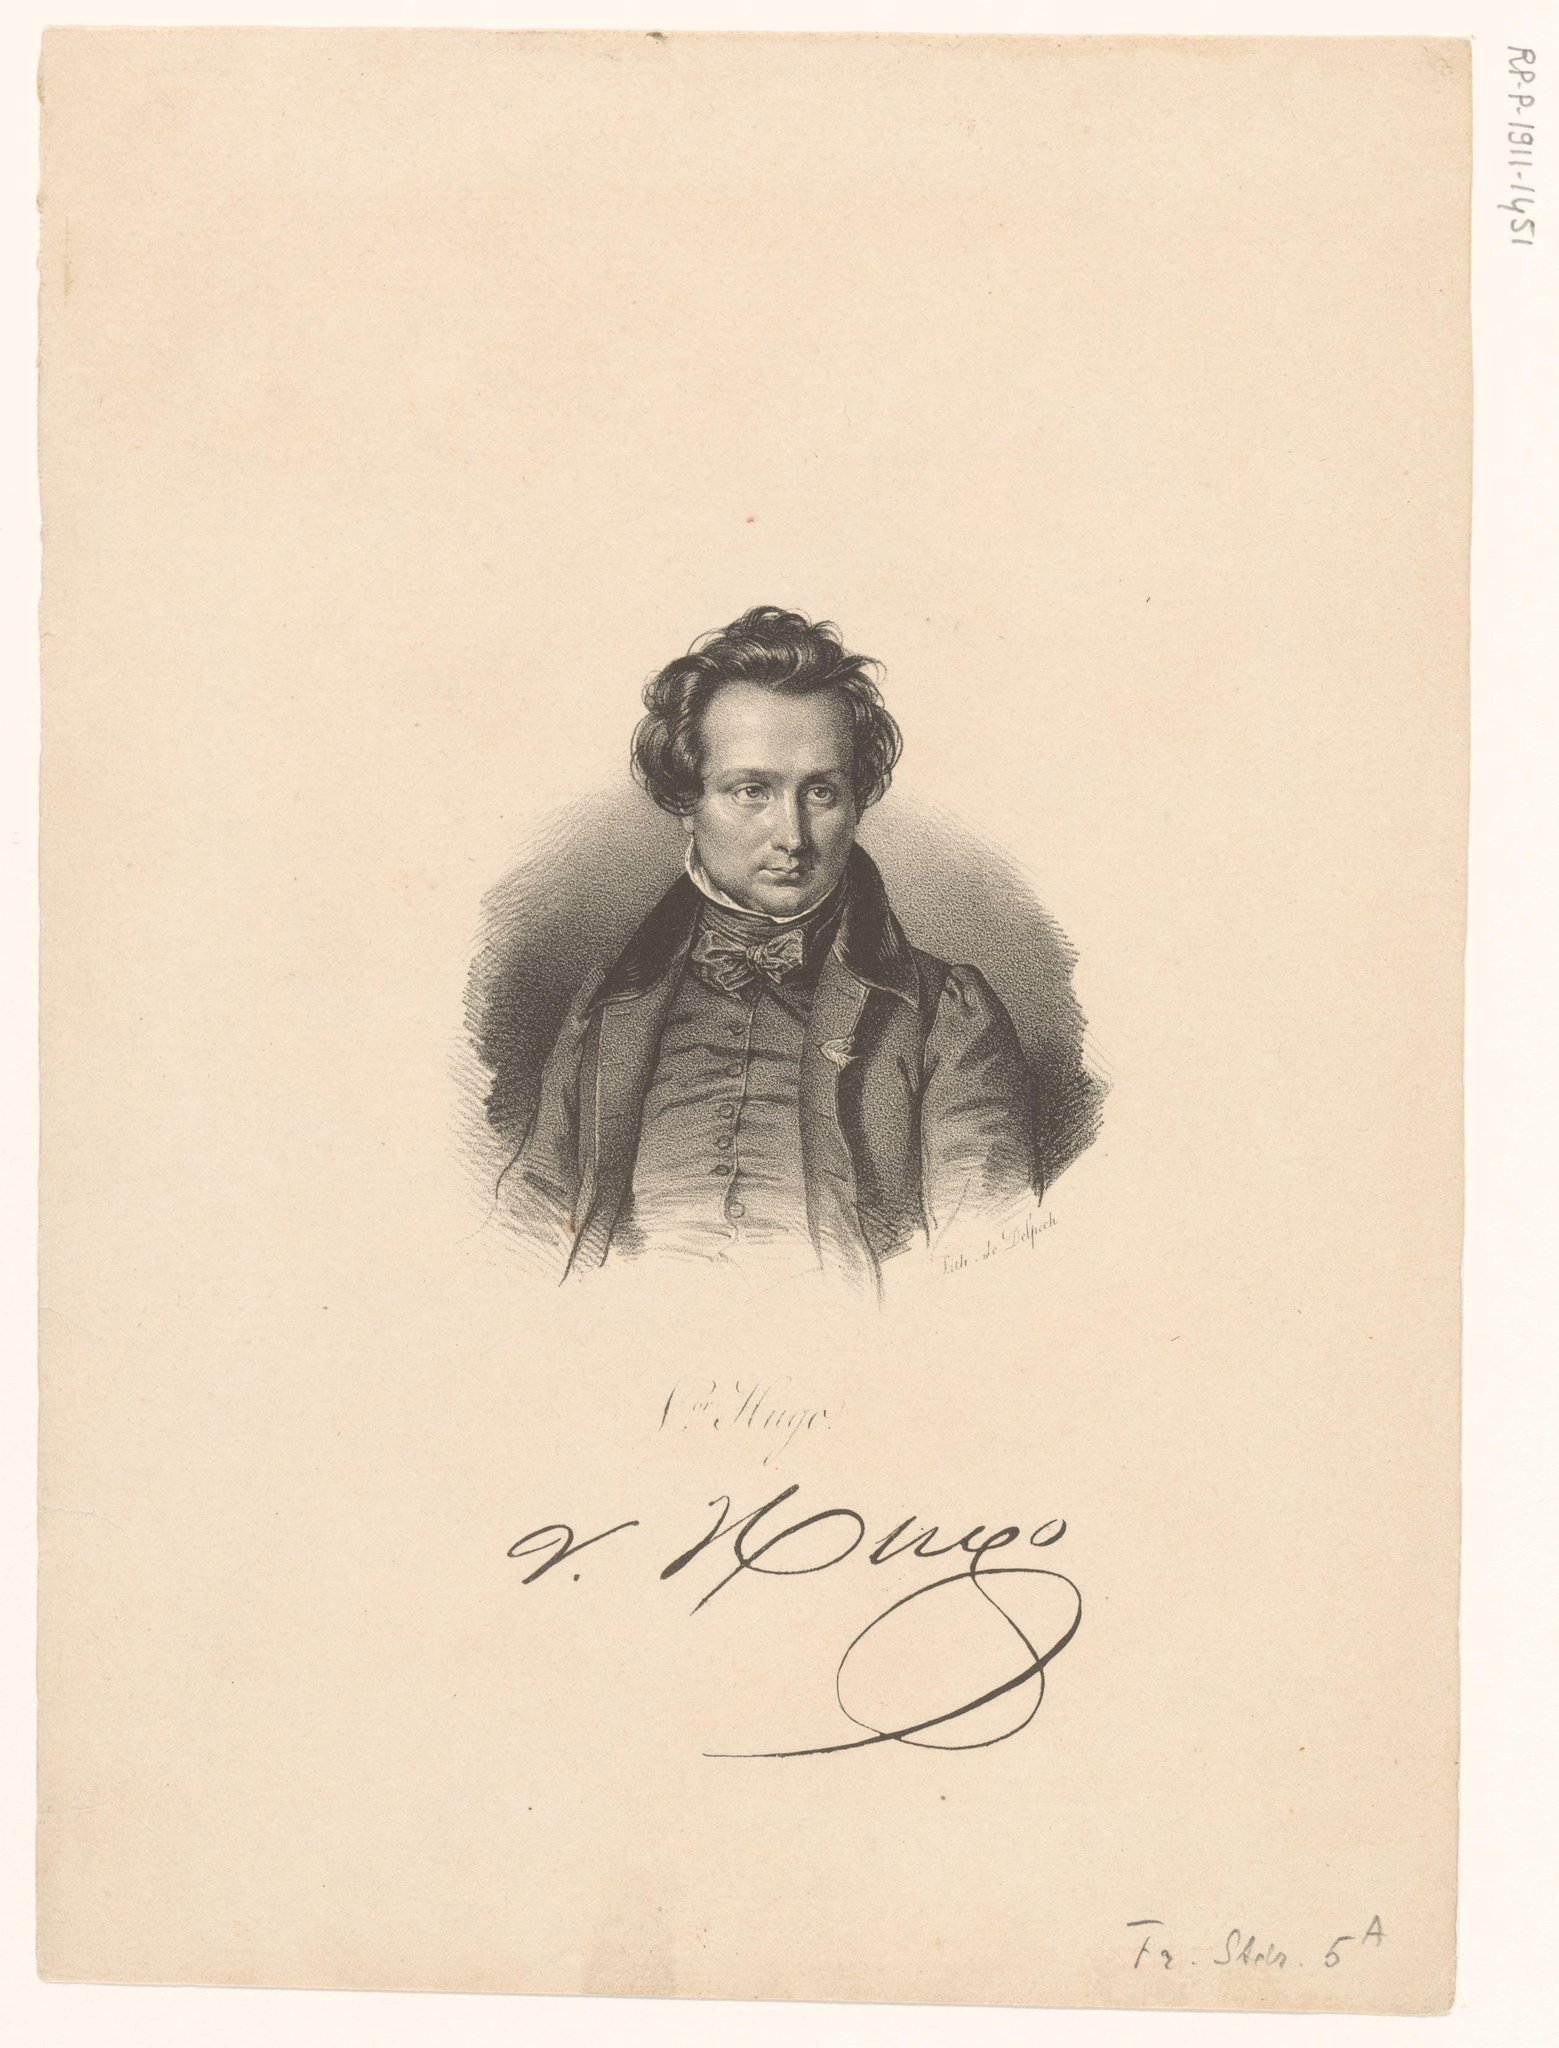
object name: print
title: V.or Hugo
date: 1818-1842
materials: paper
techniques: lithograph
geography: paris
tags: paris, victor hugo, historical persons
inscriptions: collector's mark: Lugt 2228a